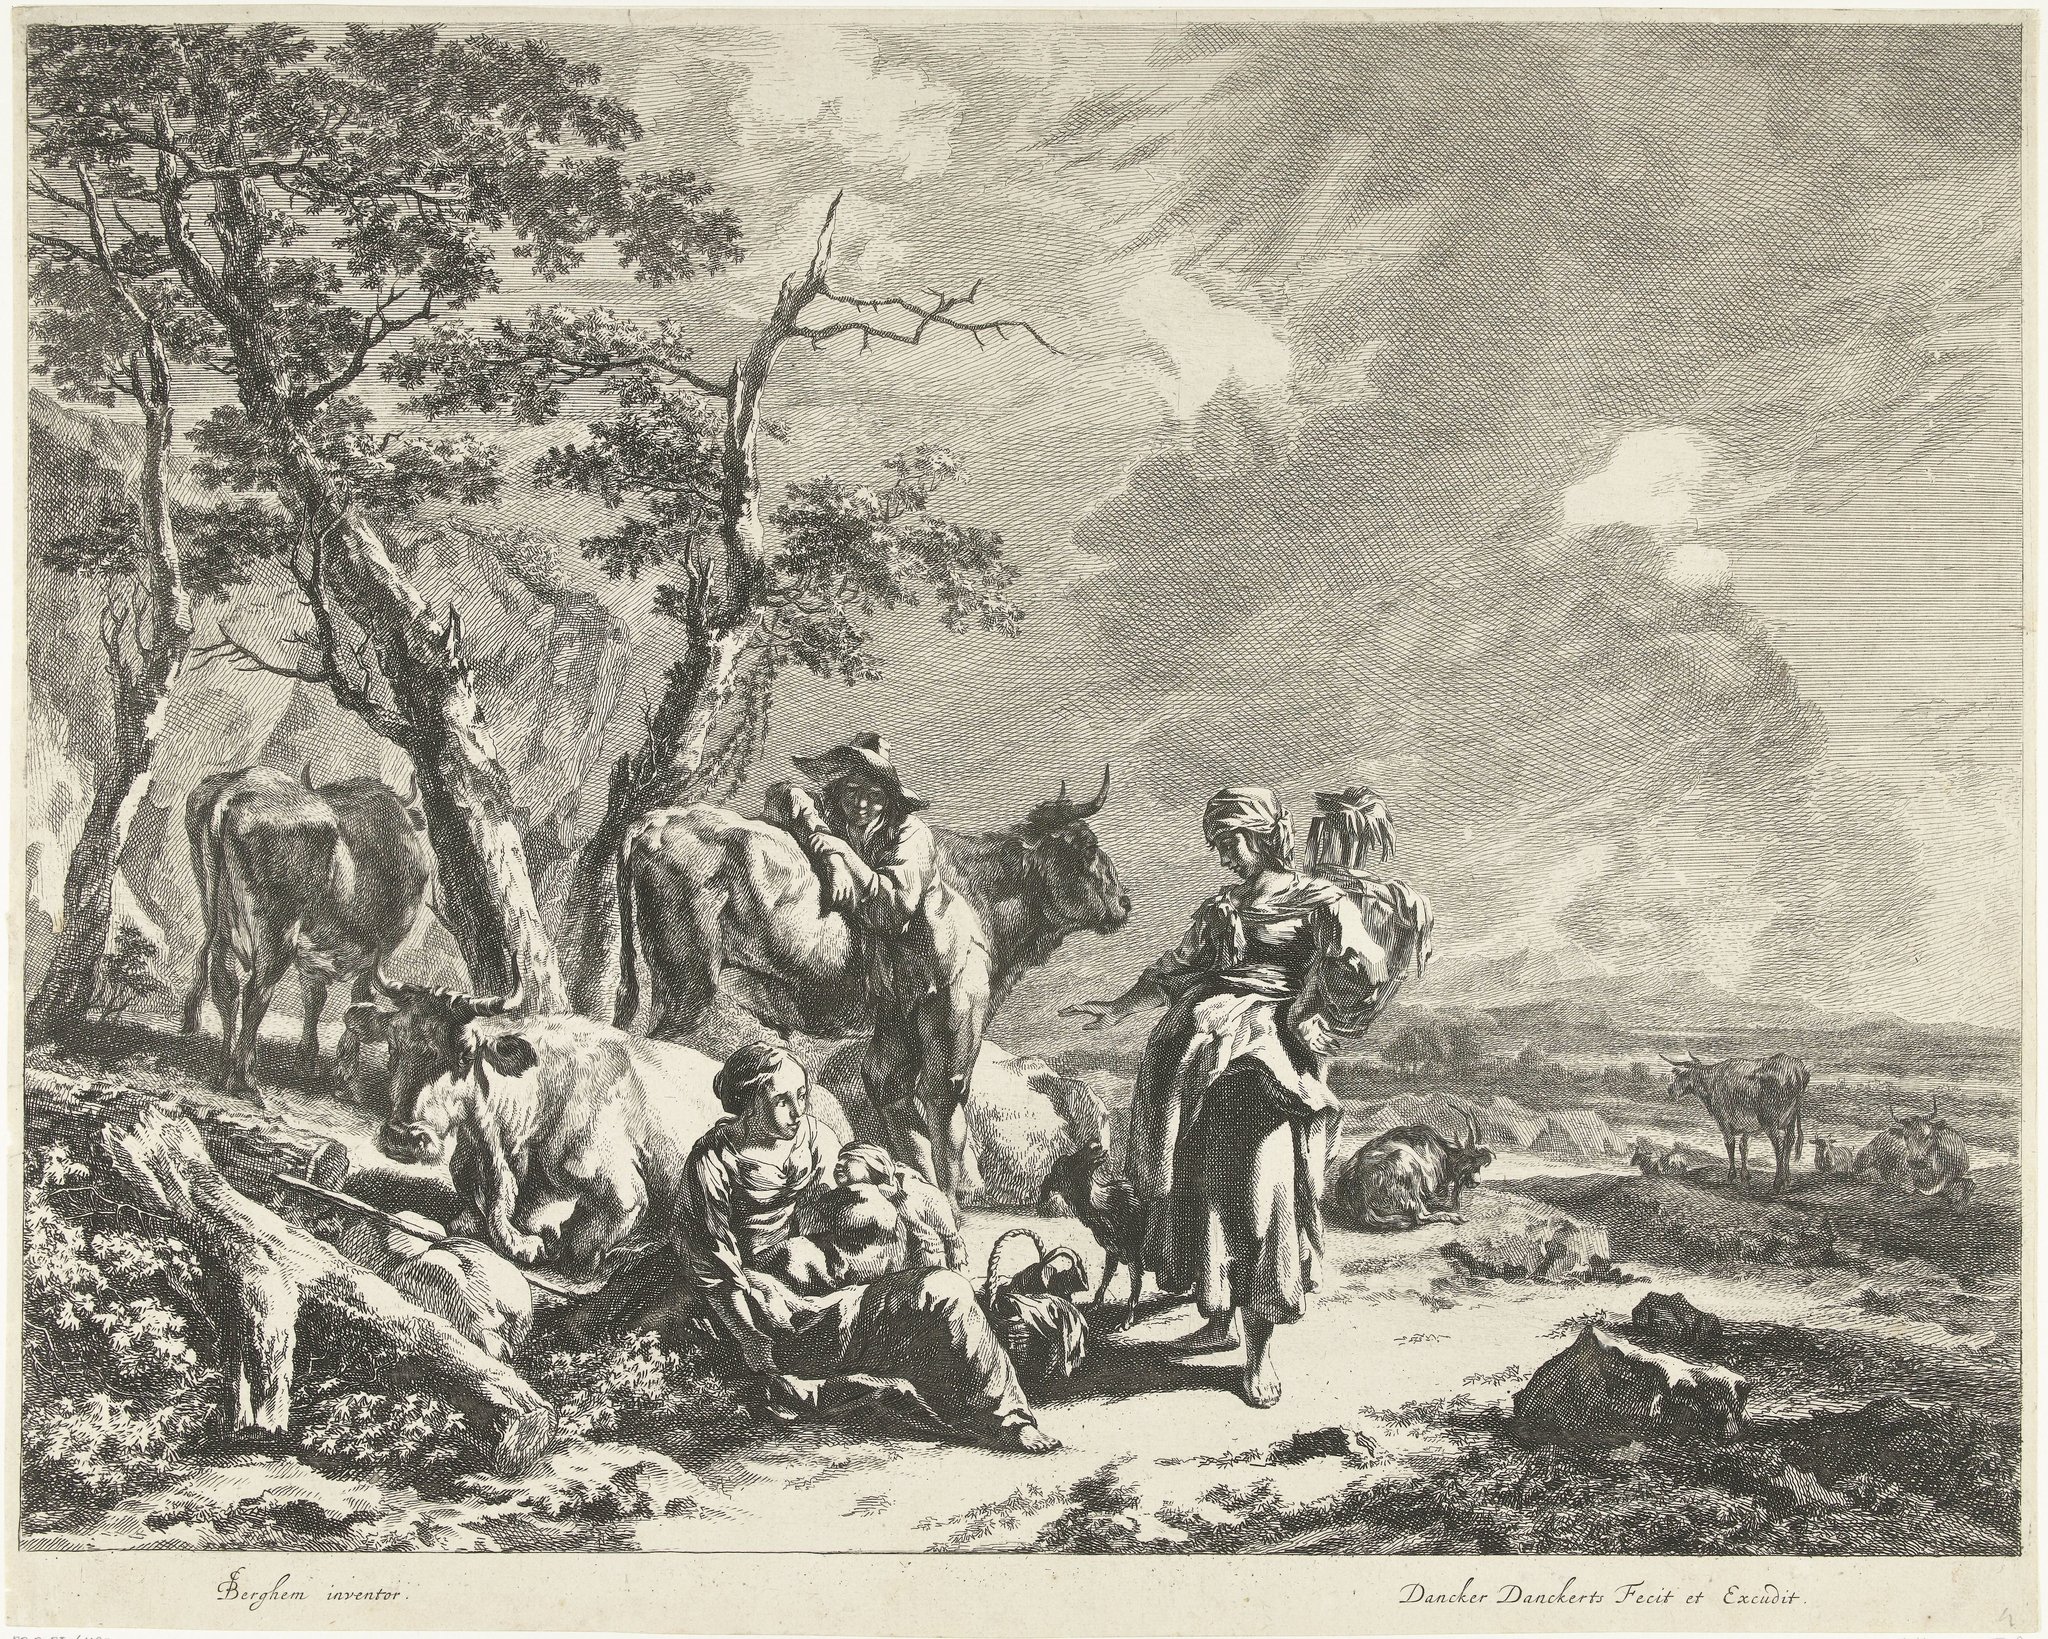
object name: print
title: Tijden van de dag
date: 1660-1666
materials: paper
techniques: etching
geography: amsterdam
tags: herding, herdsman, herdswoman, shepherd, shepherdess, cowherd, etc., afternoon ~ other concepts, rocks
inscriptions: collector's mark: Lugt 240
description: Herdersfamilie rust met kudde koeien bij bomen. Herderin zit met kind op schoot. Prent nummer 2 uit serie van vier prenten met tijden van de dag.